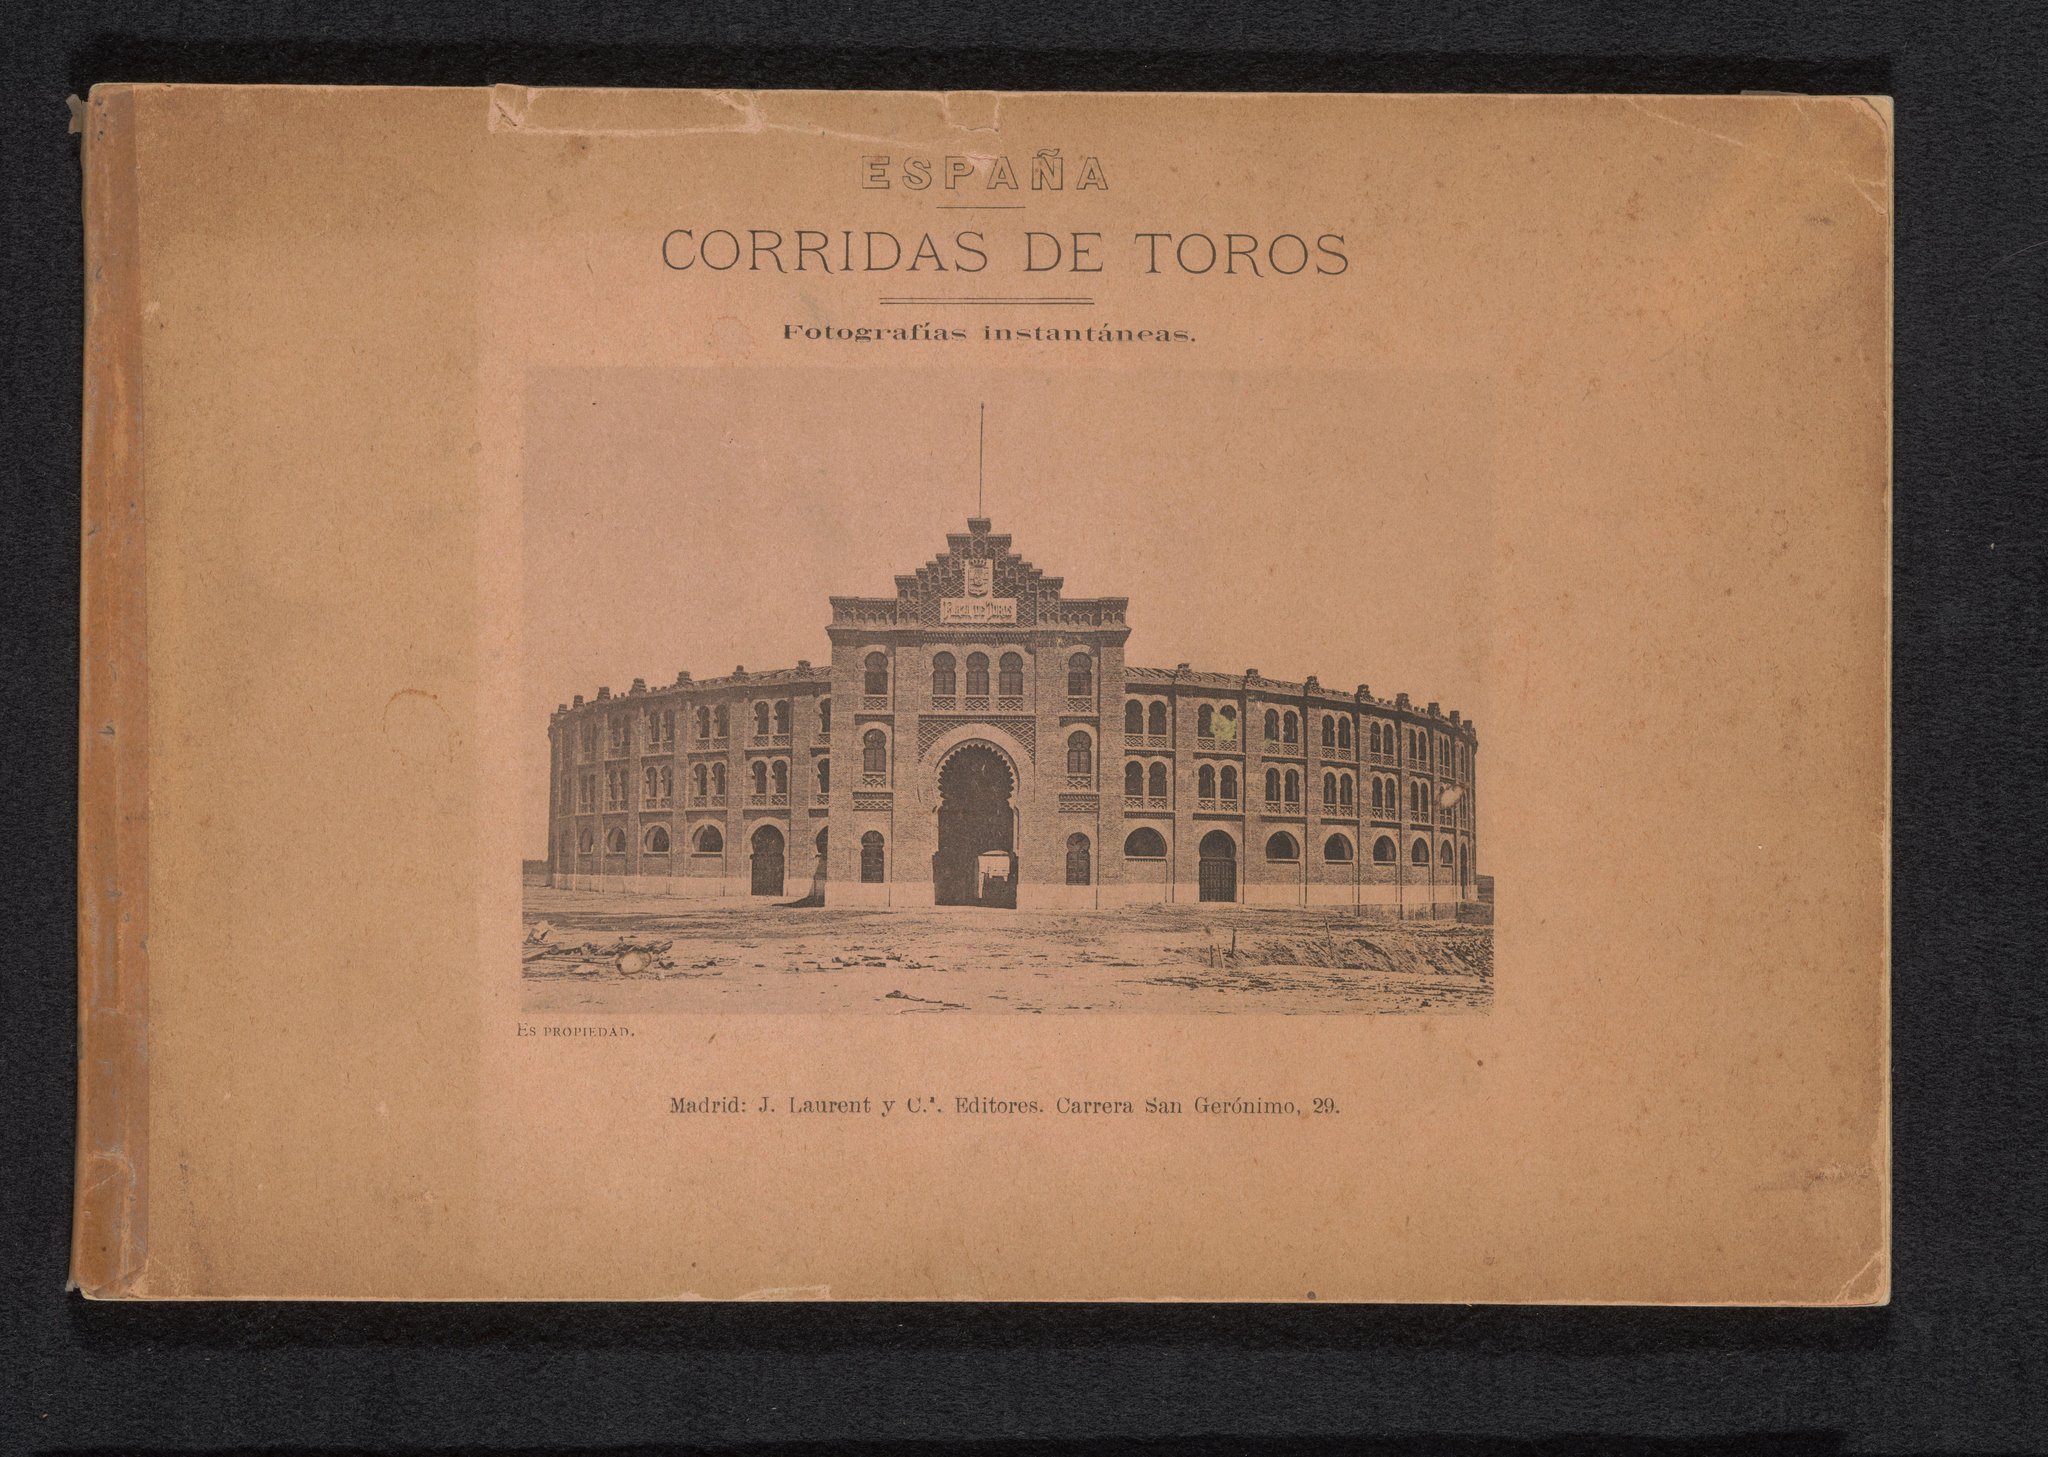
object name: photomechanical print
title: Exterieur van de stierenvechtersarena van Carretera de Aragon te Madrid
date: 1880-1890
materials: paper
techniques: photograph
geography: madrid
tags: bullfight, theatre (building) - aa - open-air performances